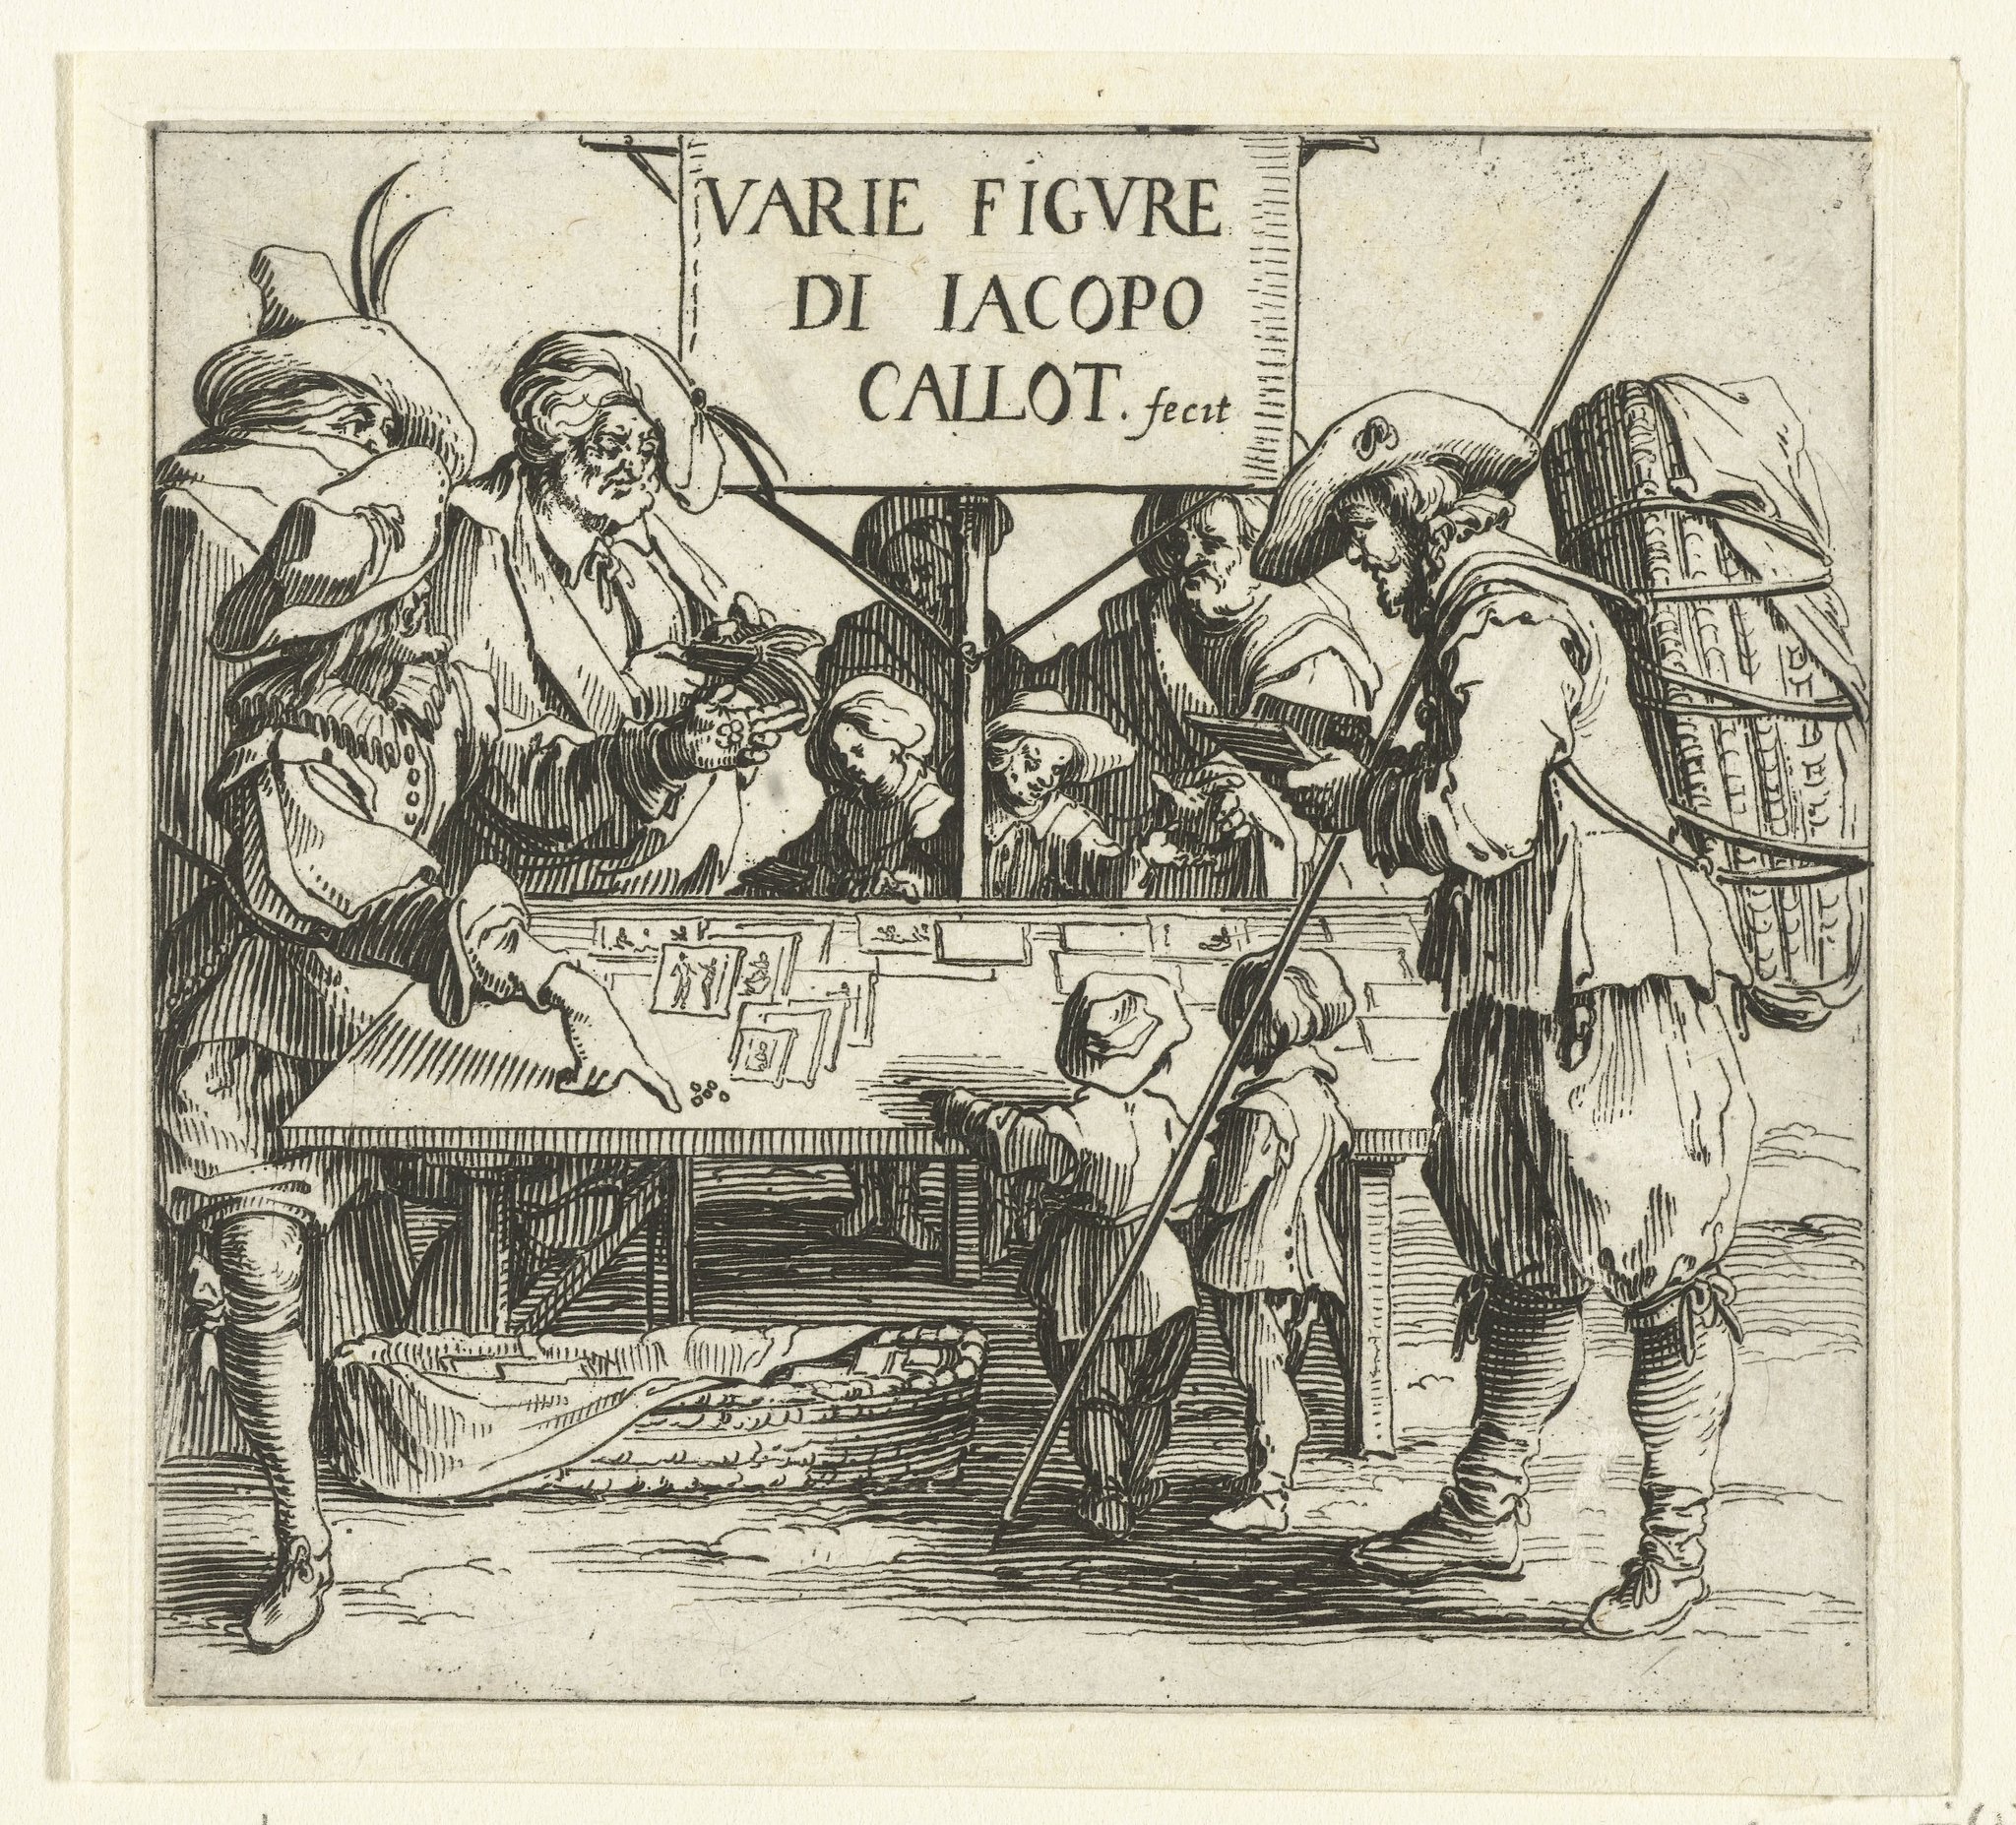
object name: print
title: Varie figure di Jacopo Callot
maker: jacques callot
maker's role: draughtsman, print maker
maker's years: 1592-1635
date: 1621-1624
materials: paper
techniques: etching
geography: nancy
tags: print, e.g.: engraving, etching, lithograph, buying and selling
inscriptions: collector's mark: Lugt 240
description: Een prenthandelaar aan een tafel, waarop hij zijn waar uitgestald heeft. Een groep klanten heeft zich om zijn tafel geschaard, onder hen enkele kinderen en een man met een groot pak op zijn rug. Bij de tafel staat een bord met daarop titel en maker van de prentreeks. Dit is namelijk de titelprent voor een serie van 16 prenten (15 volgens Lieure) met mannen en vrouwen in diverse houdingen. Mogelijk zijn deze prenten bedoeld geweest als tekenvoorbeelden.